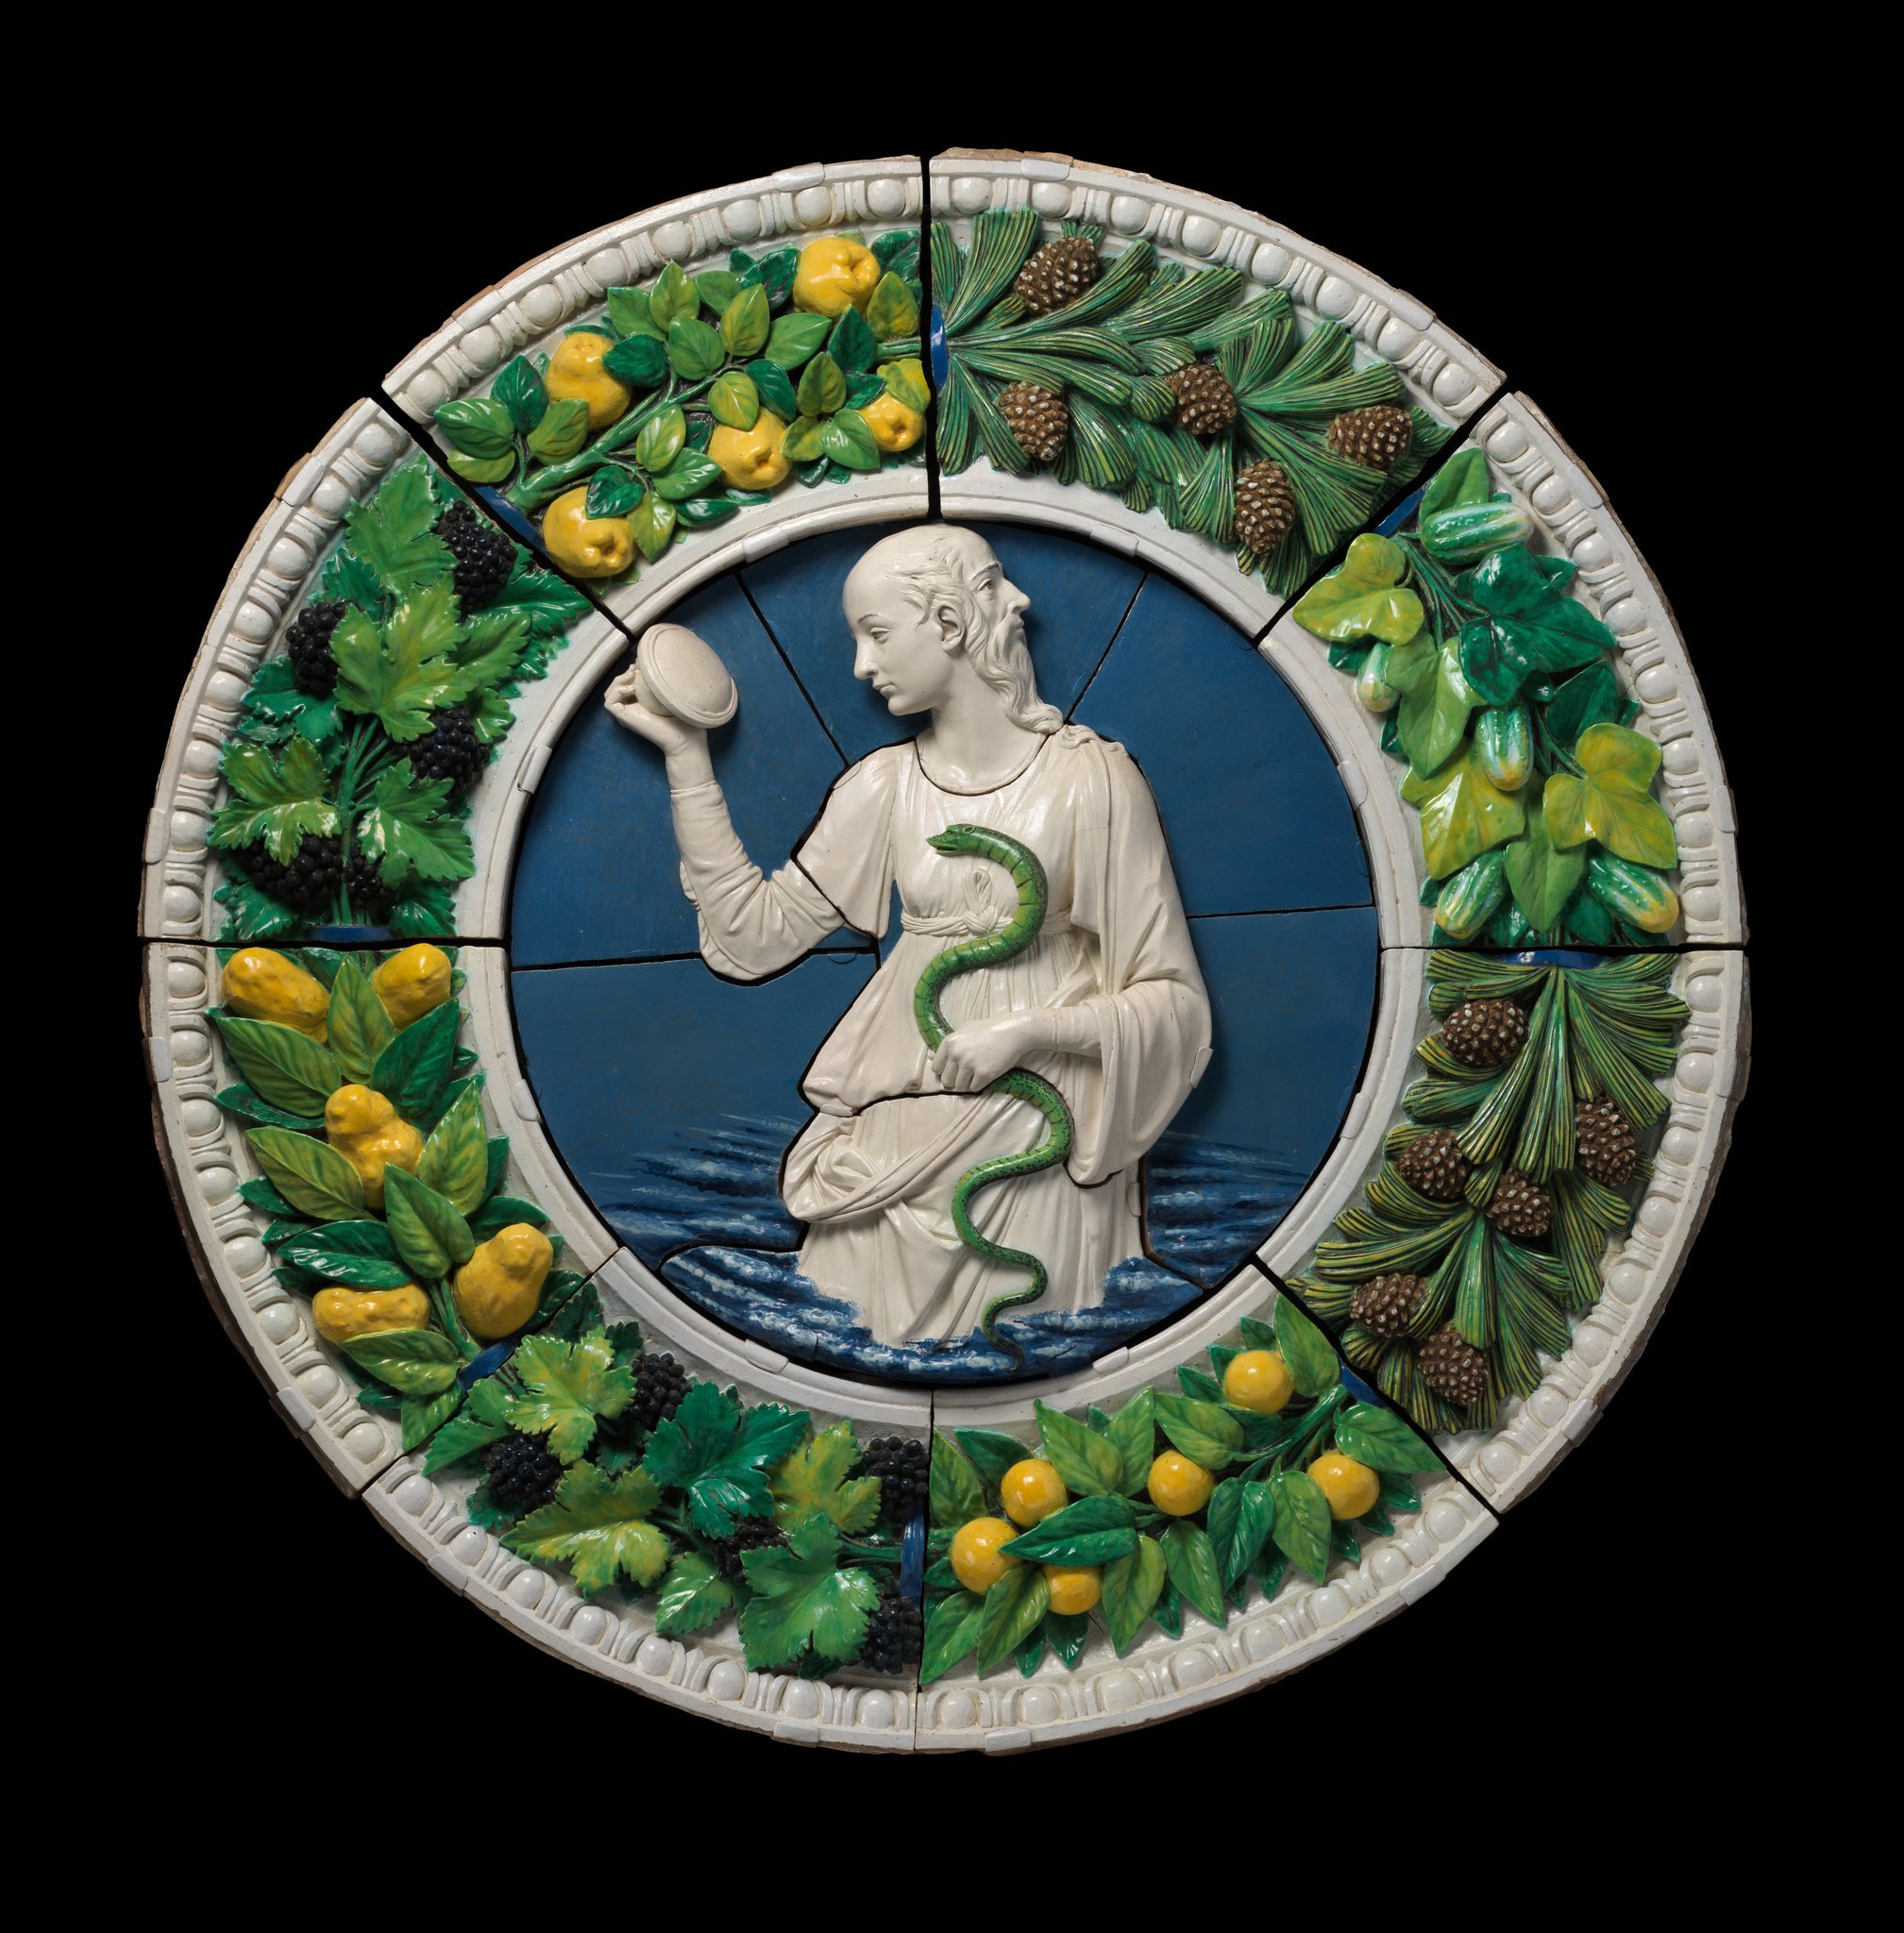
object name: tondo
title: Prudence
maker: andrea della robbia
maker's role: artist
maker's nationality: italian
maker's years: 1435-1525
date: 1475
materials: terracotta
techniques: glazing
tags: fruit,grapes,women,snakes